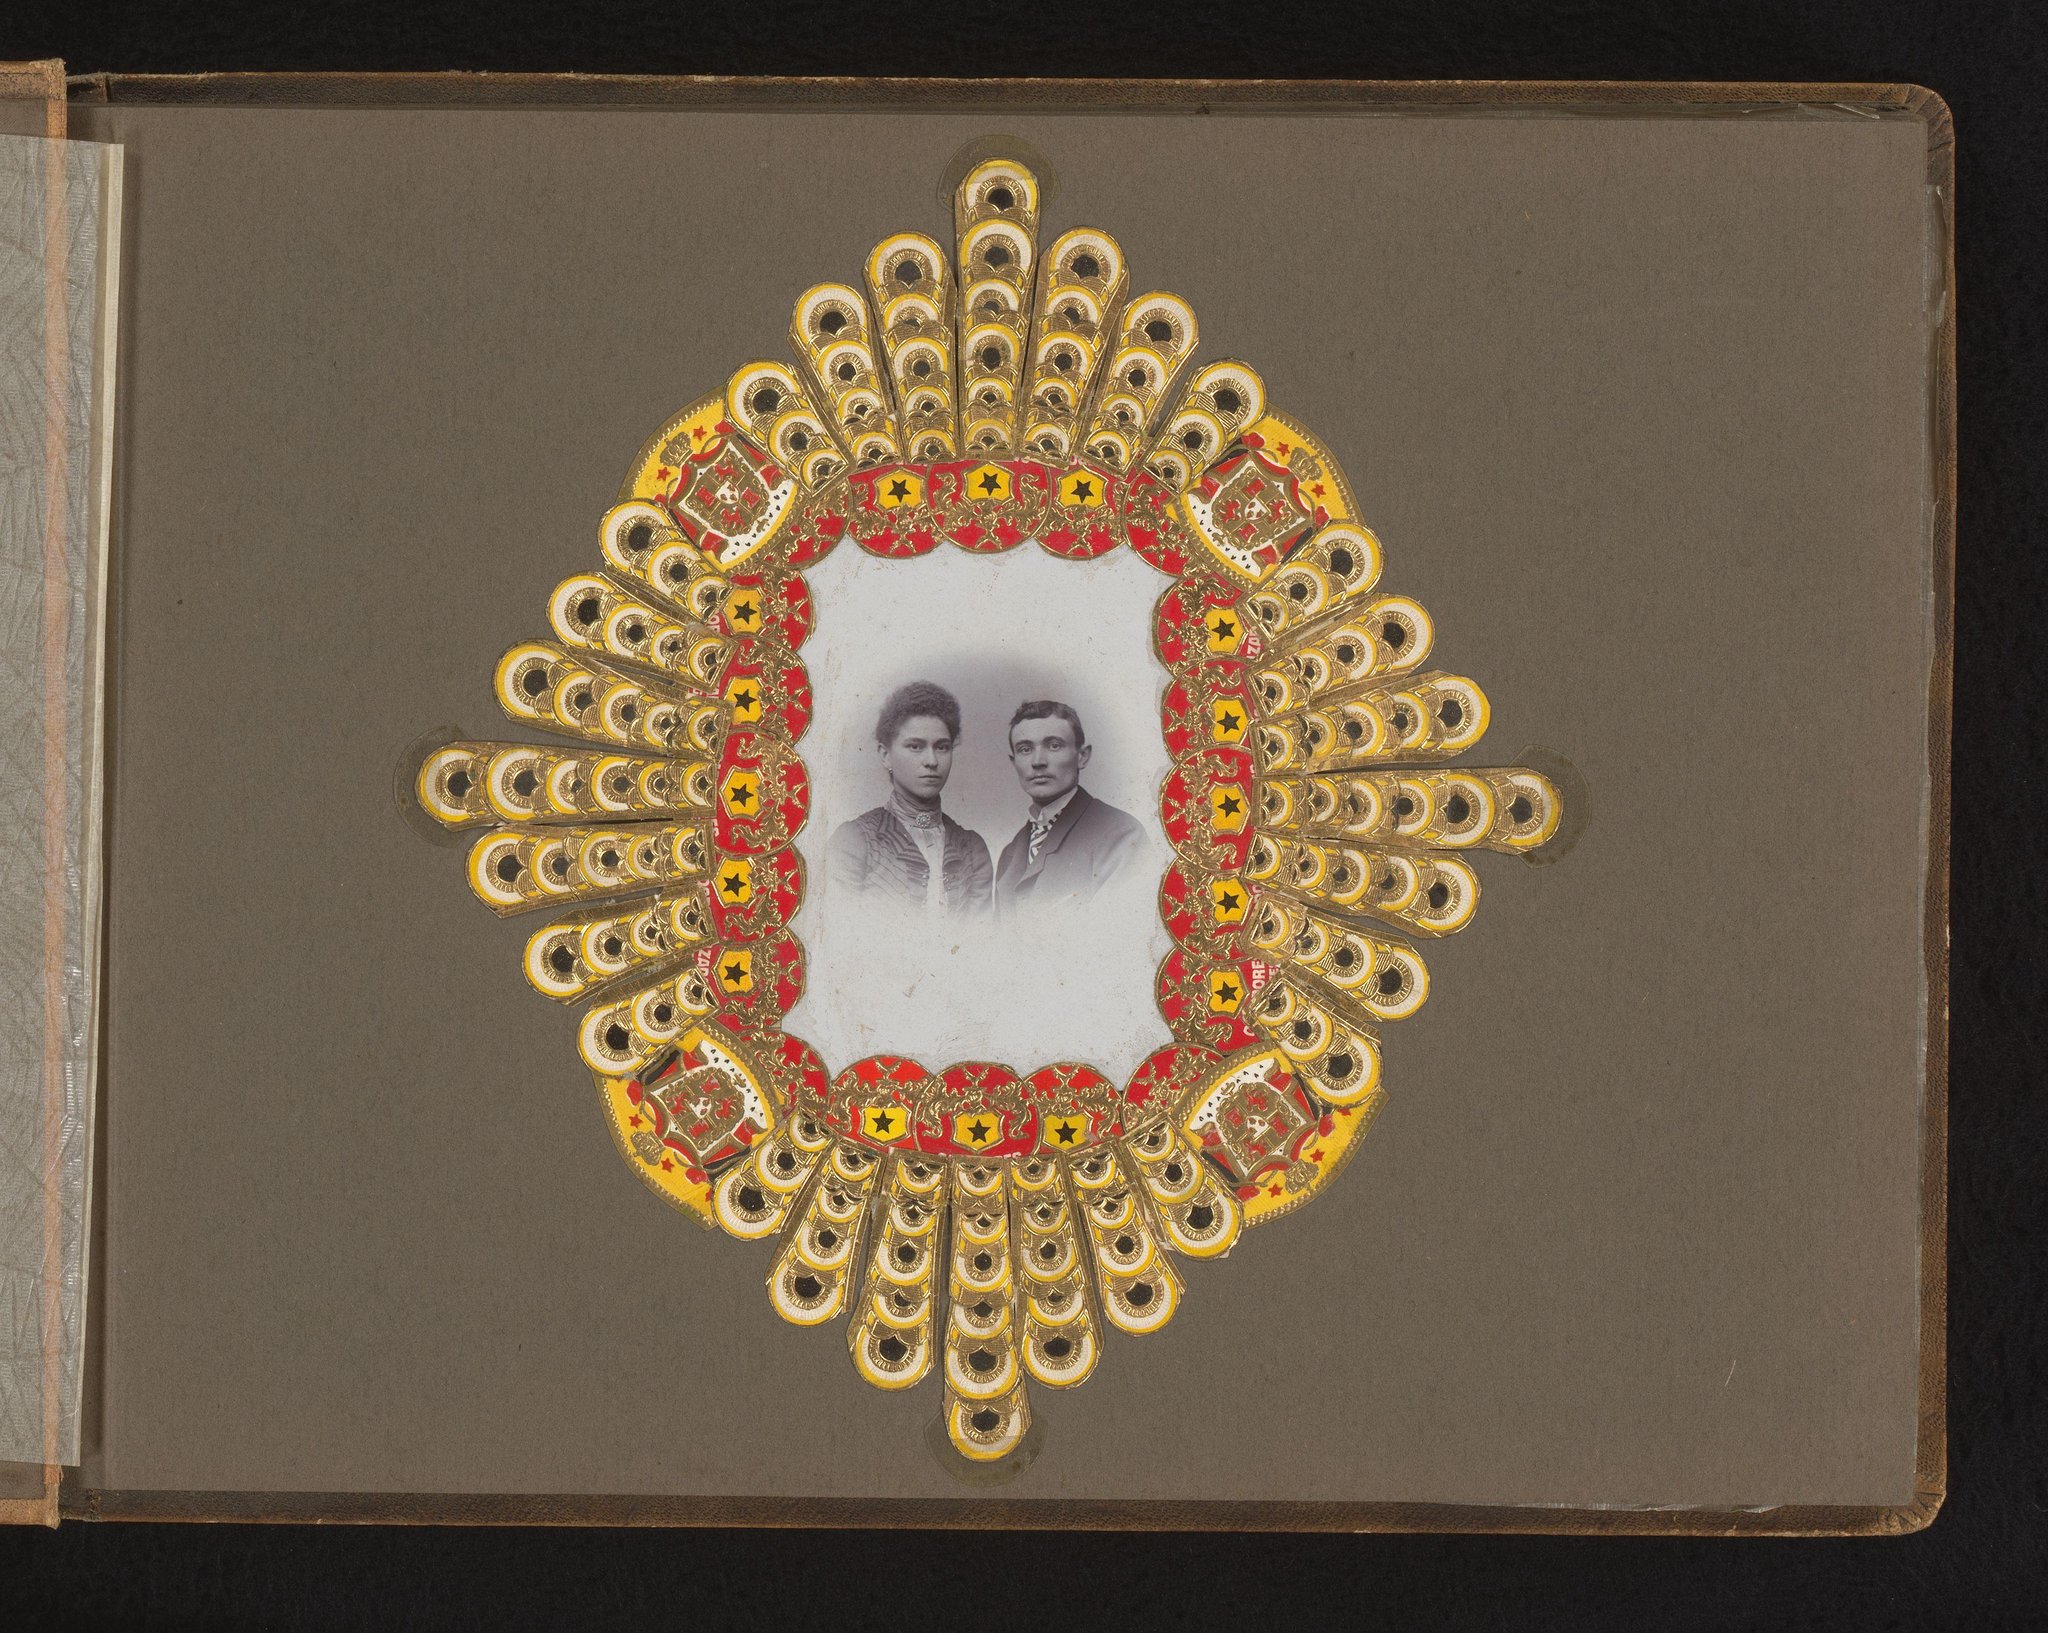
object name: photograph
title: Portret van een man en vrouw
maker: Anonymous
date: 1900-1950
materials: photographic support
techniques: collodion silver print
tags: adult woman, adult man, historical persons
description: Om het portret een geknutselde passe-partout, vermoedelijk gemaakt van sigarenbandjes. Deze pagina maakt deel uit van een album.